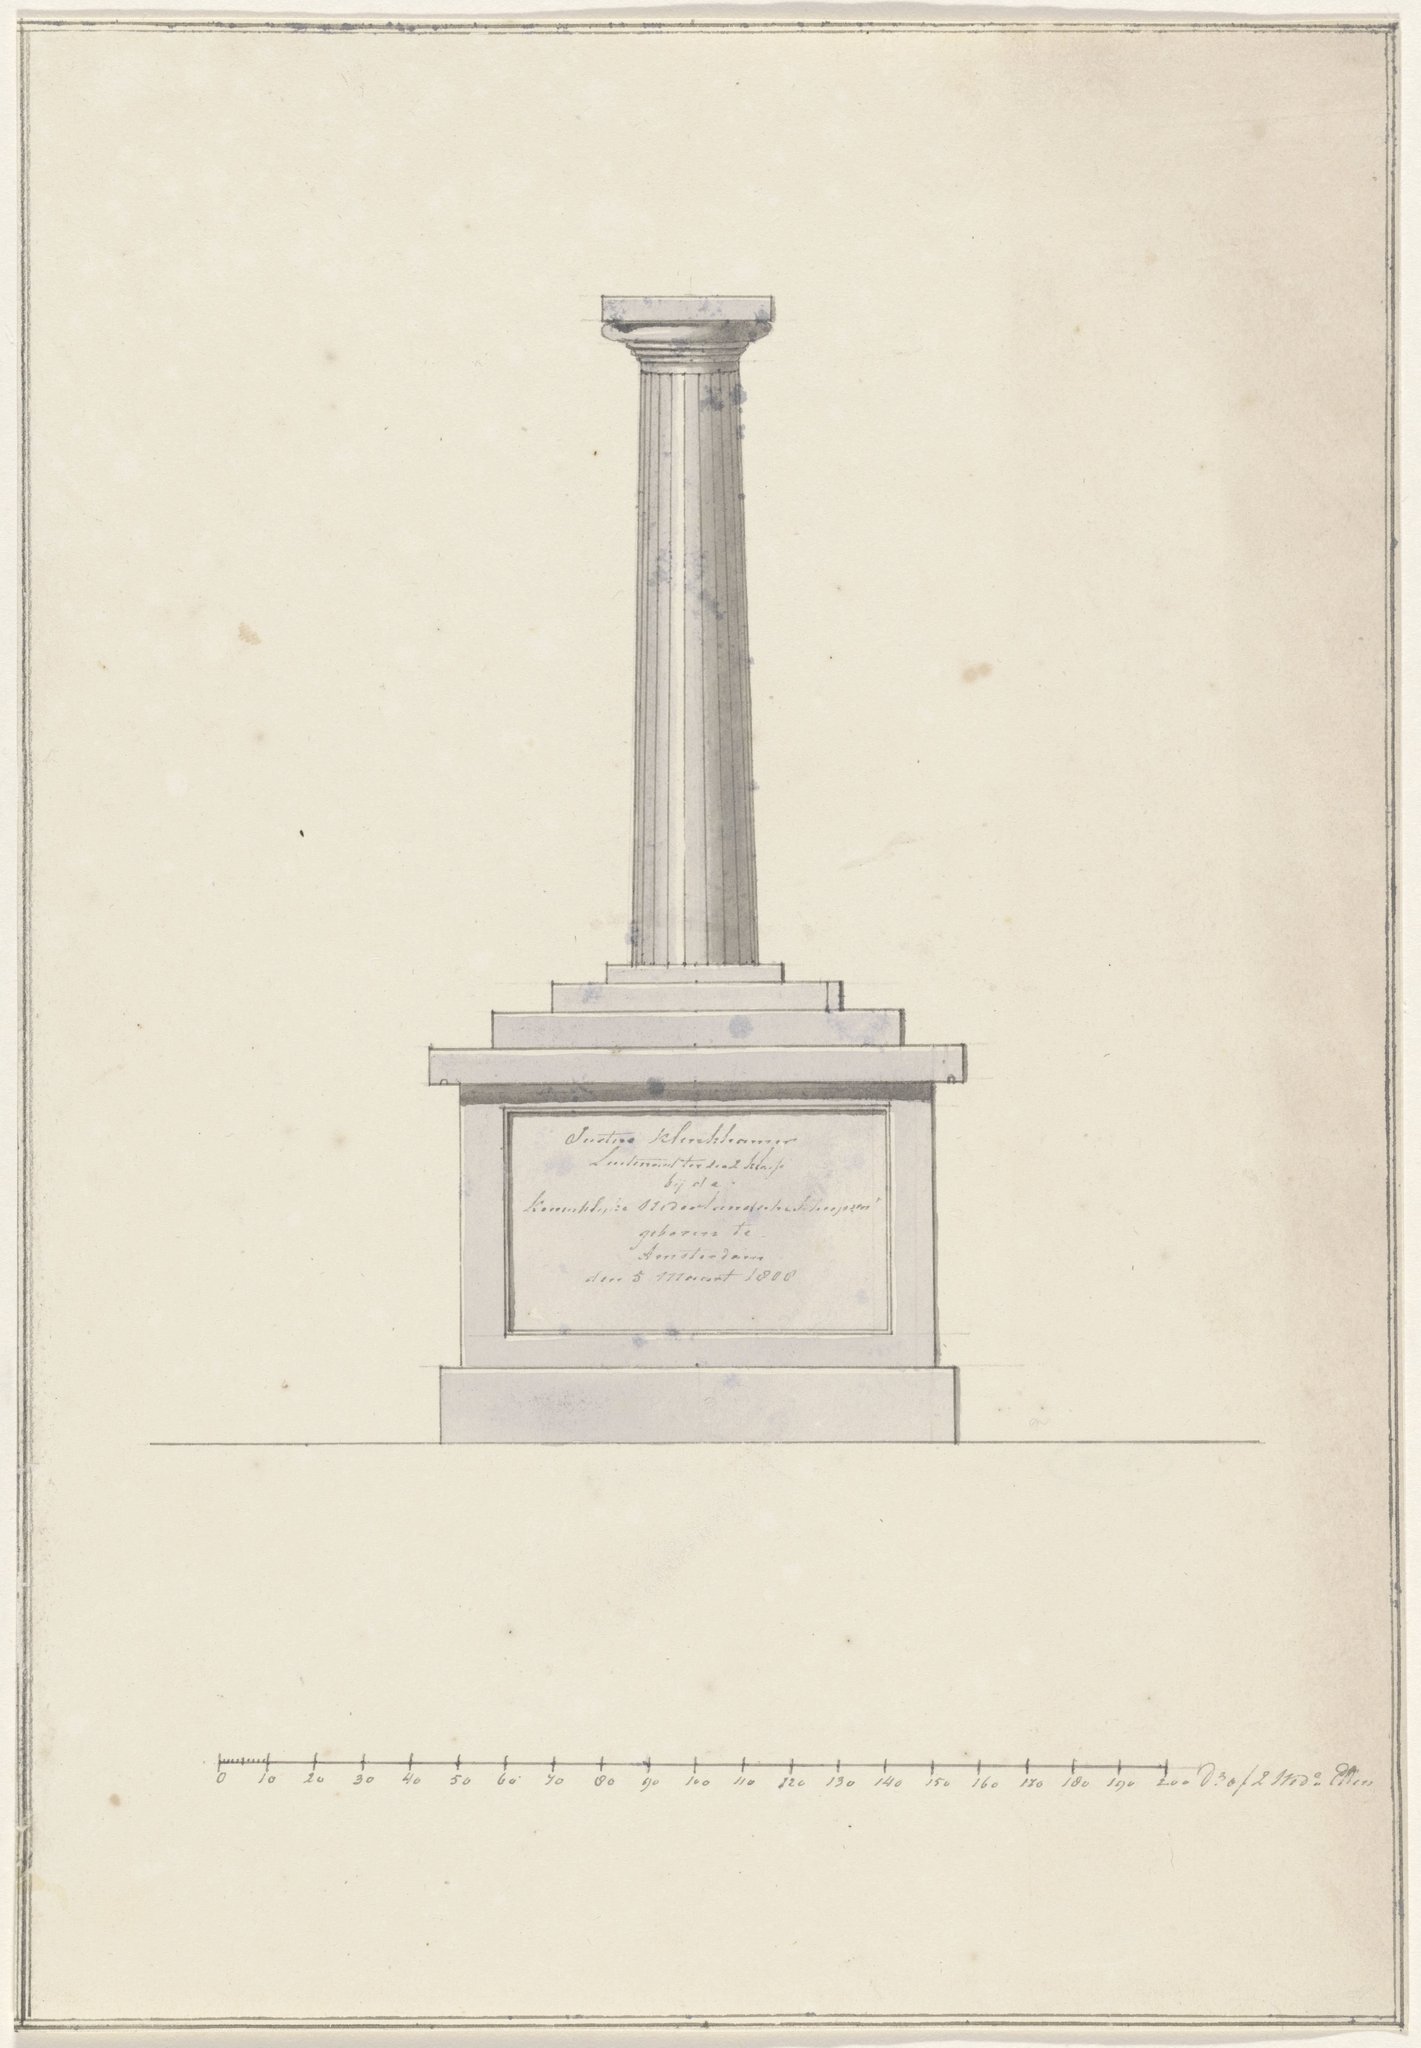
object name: drawing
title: Grafmonument voor Justus Klinkhamer, 1830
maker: Anonymous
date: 1830-1831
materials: paper, pencil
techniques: brush, pen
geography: netherlands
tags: amsterdam, grave, tomb, flushing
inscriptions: collector's mark: Lugt 2228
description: Het grafmonument voor Justus Klinkhamer op het kerkhof te Vlissingen. Klinkhamer, luitenant ter zee tweede klasse, raakte gewond tijdens het bombardement op Antwerpen op 27 oktober 1830 en stierf 2 dagen later. Het monument heeft de vorm van een zuil op een voetstuk. Onderaan de schaal.